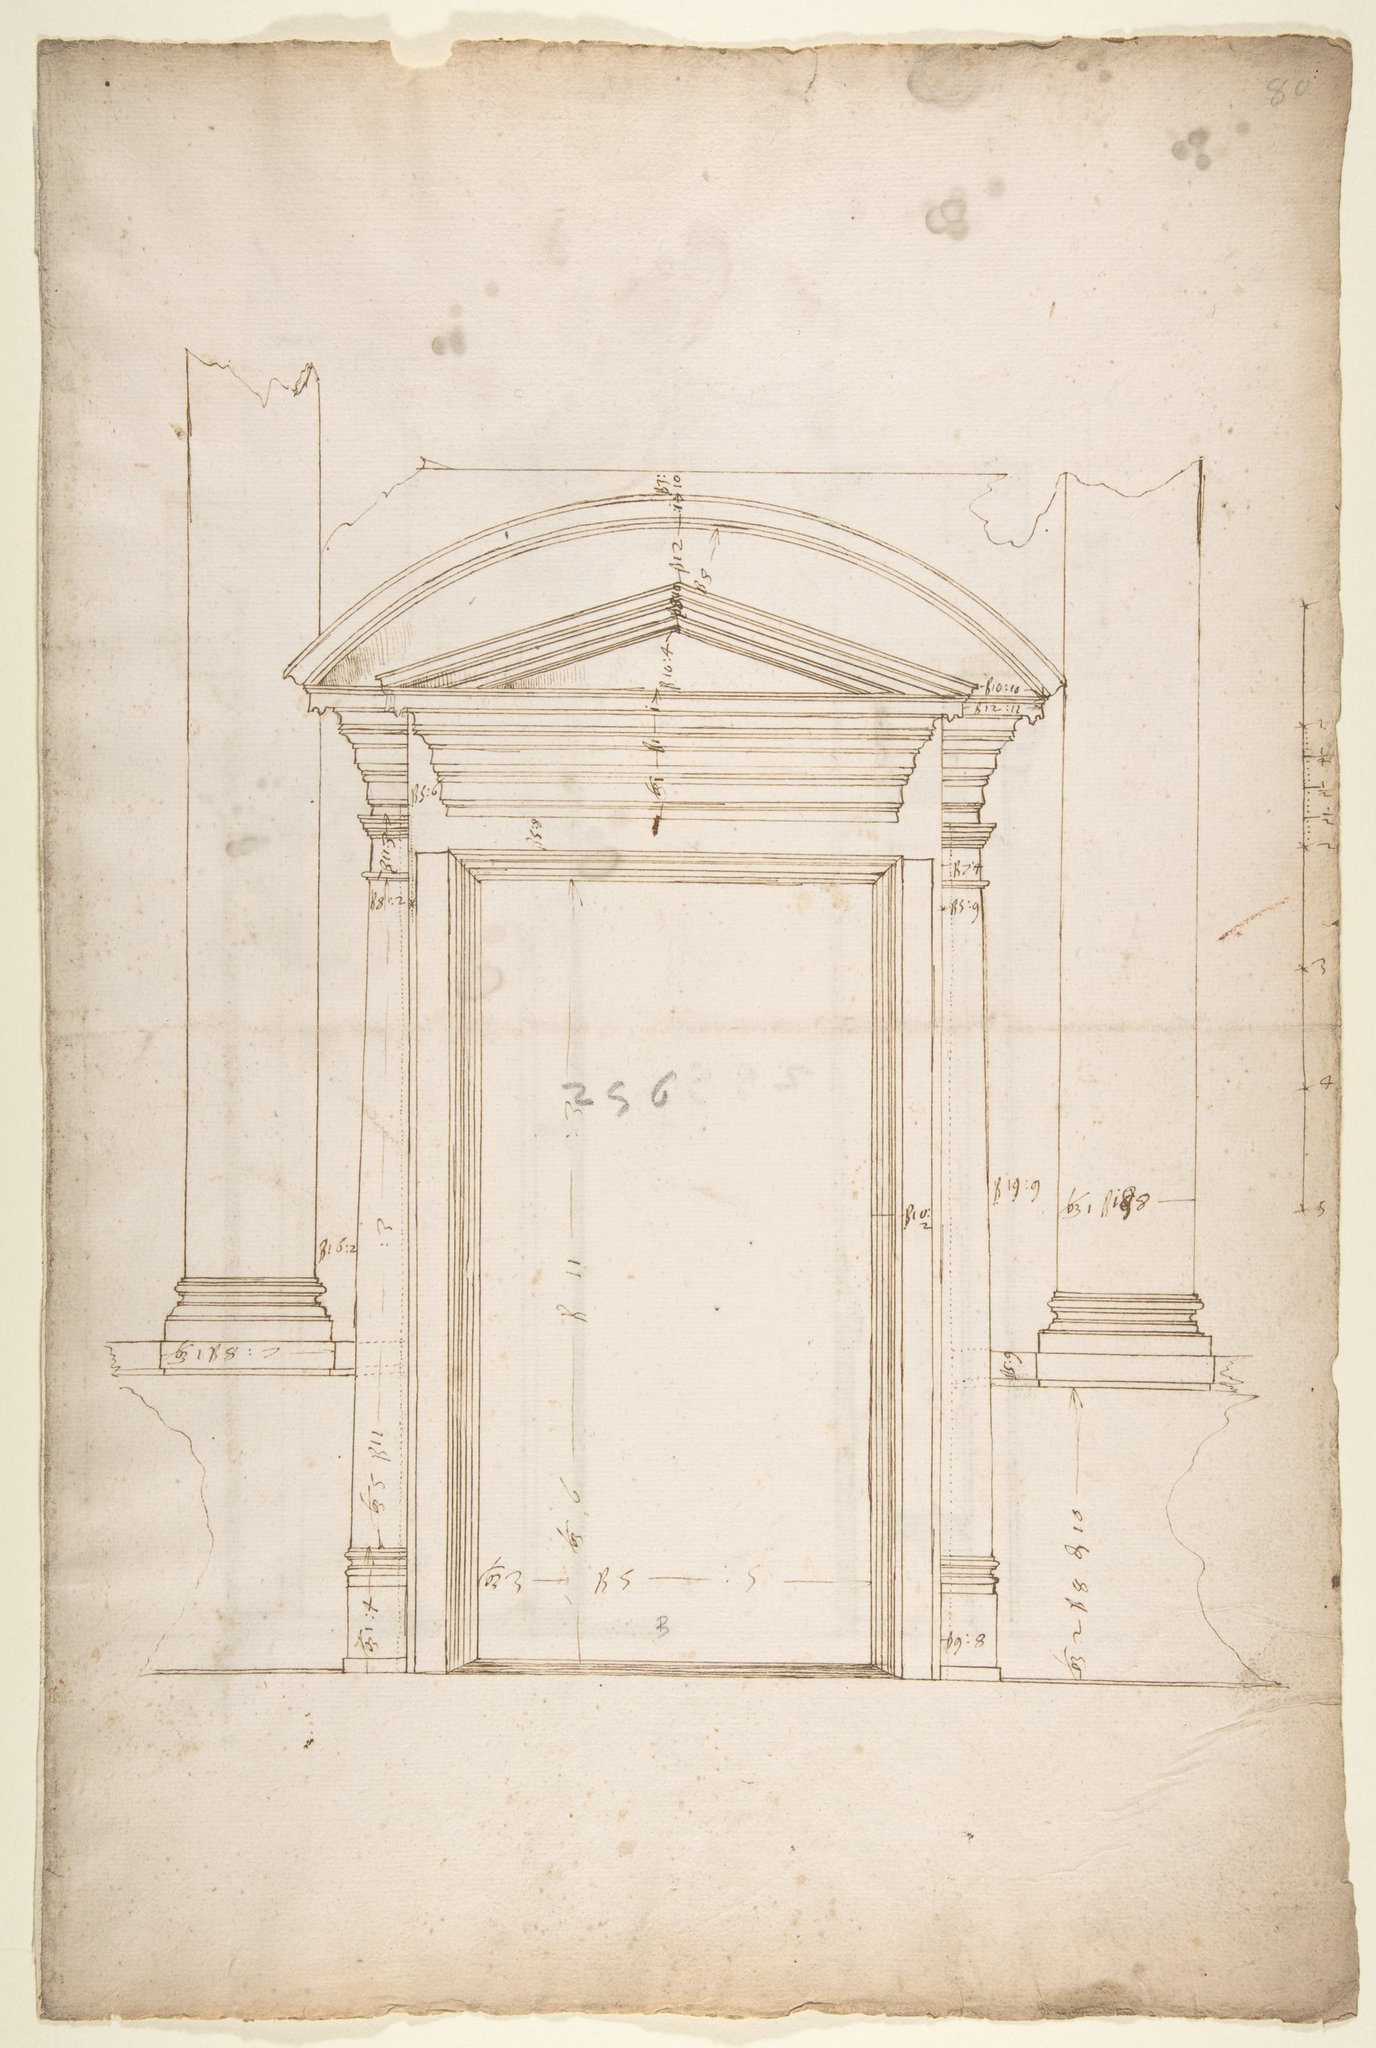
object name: drawing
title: San Lorenzo, Library, entry portal to library, elevation (recto) San Lorenzo, Library, entry portal to library, section; entry portal to library, side elevation (verso)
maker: anonymous, french, 16th century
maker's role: draftsman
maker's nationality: french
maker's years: 1500-1600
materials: chalk, ink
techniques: incising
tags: architecture